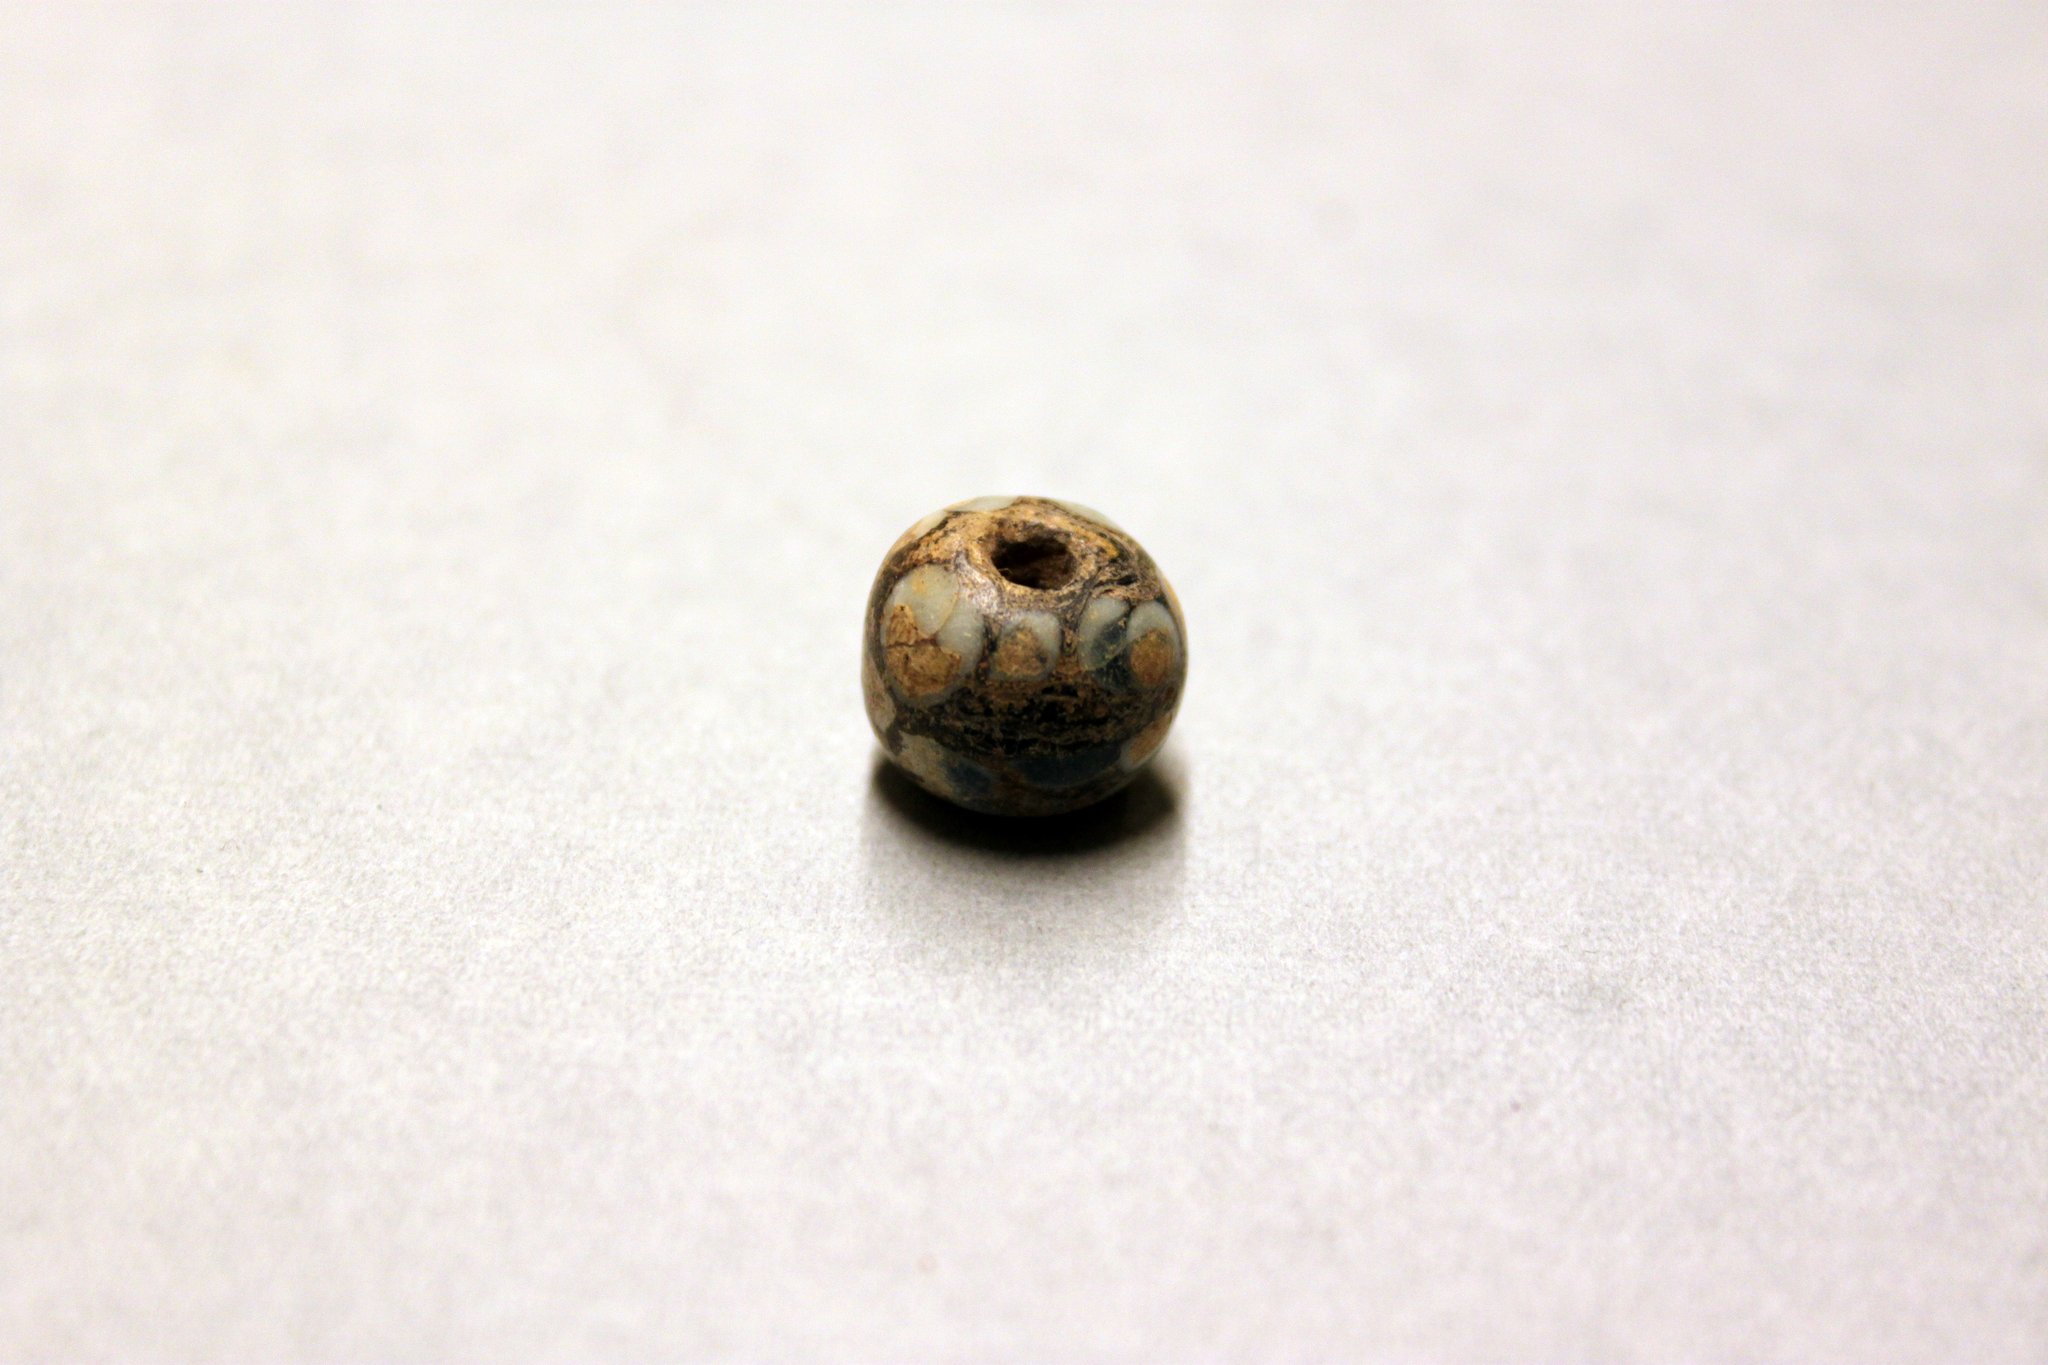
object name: bead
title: Beads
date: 701-1300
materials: glass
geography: iran